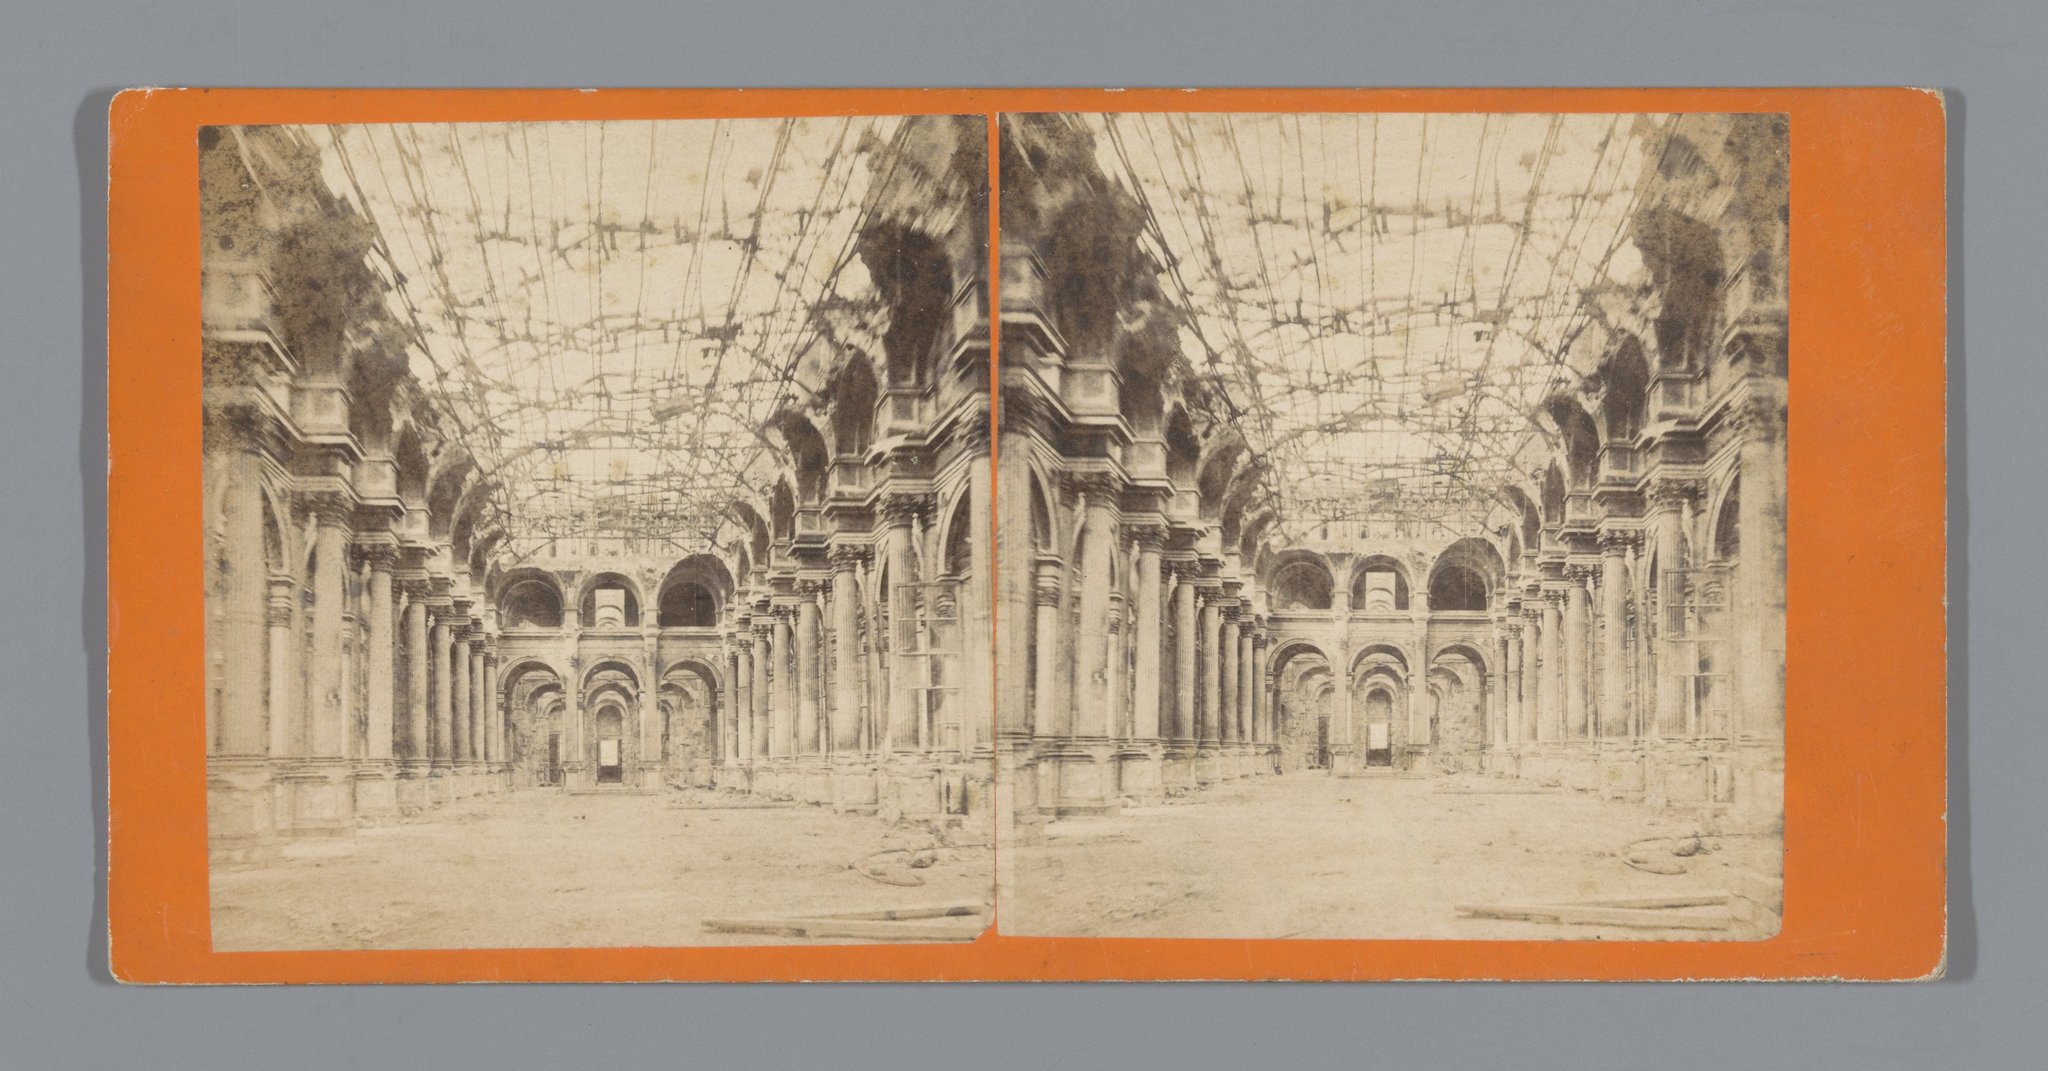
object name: stereograph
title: Ruïne van de glazen galerij van het Stadhuis van Parijs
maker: Anonymous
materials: cardboard, photographic support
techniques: albumen print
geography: paris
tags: ruin of a building ~ architecture, townhall, gallery (spacious corridor)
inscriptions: inscription: ‘Galerie vitré de l'Hotel de Ville’